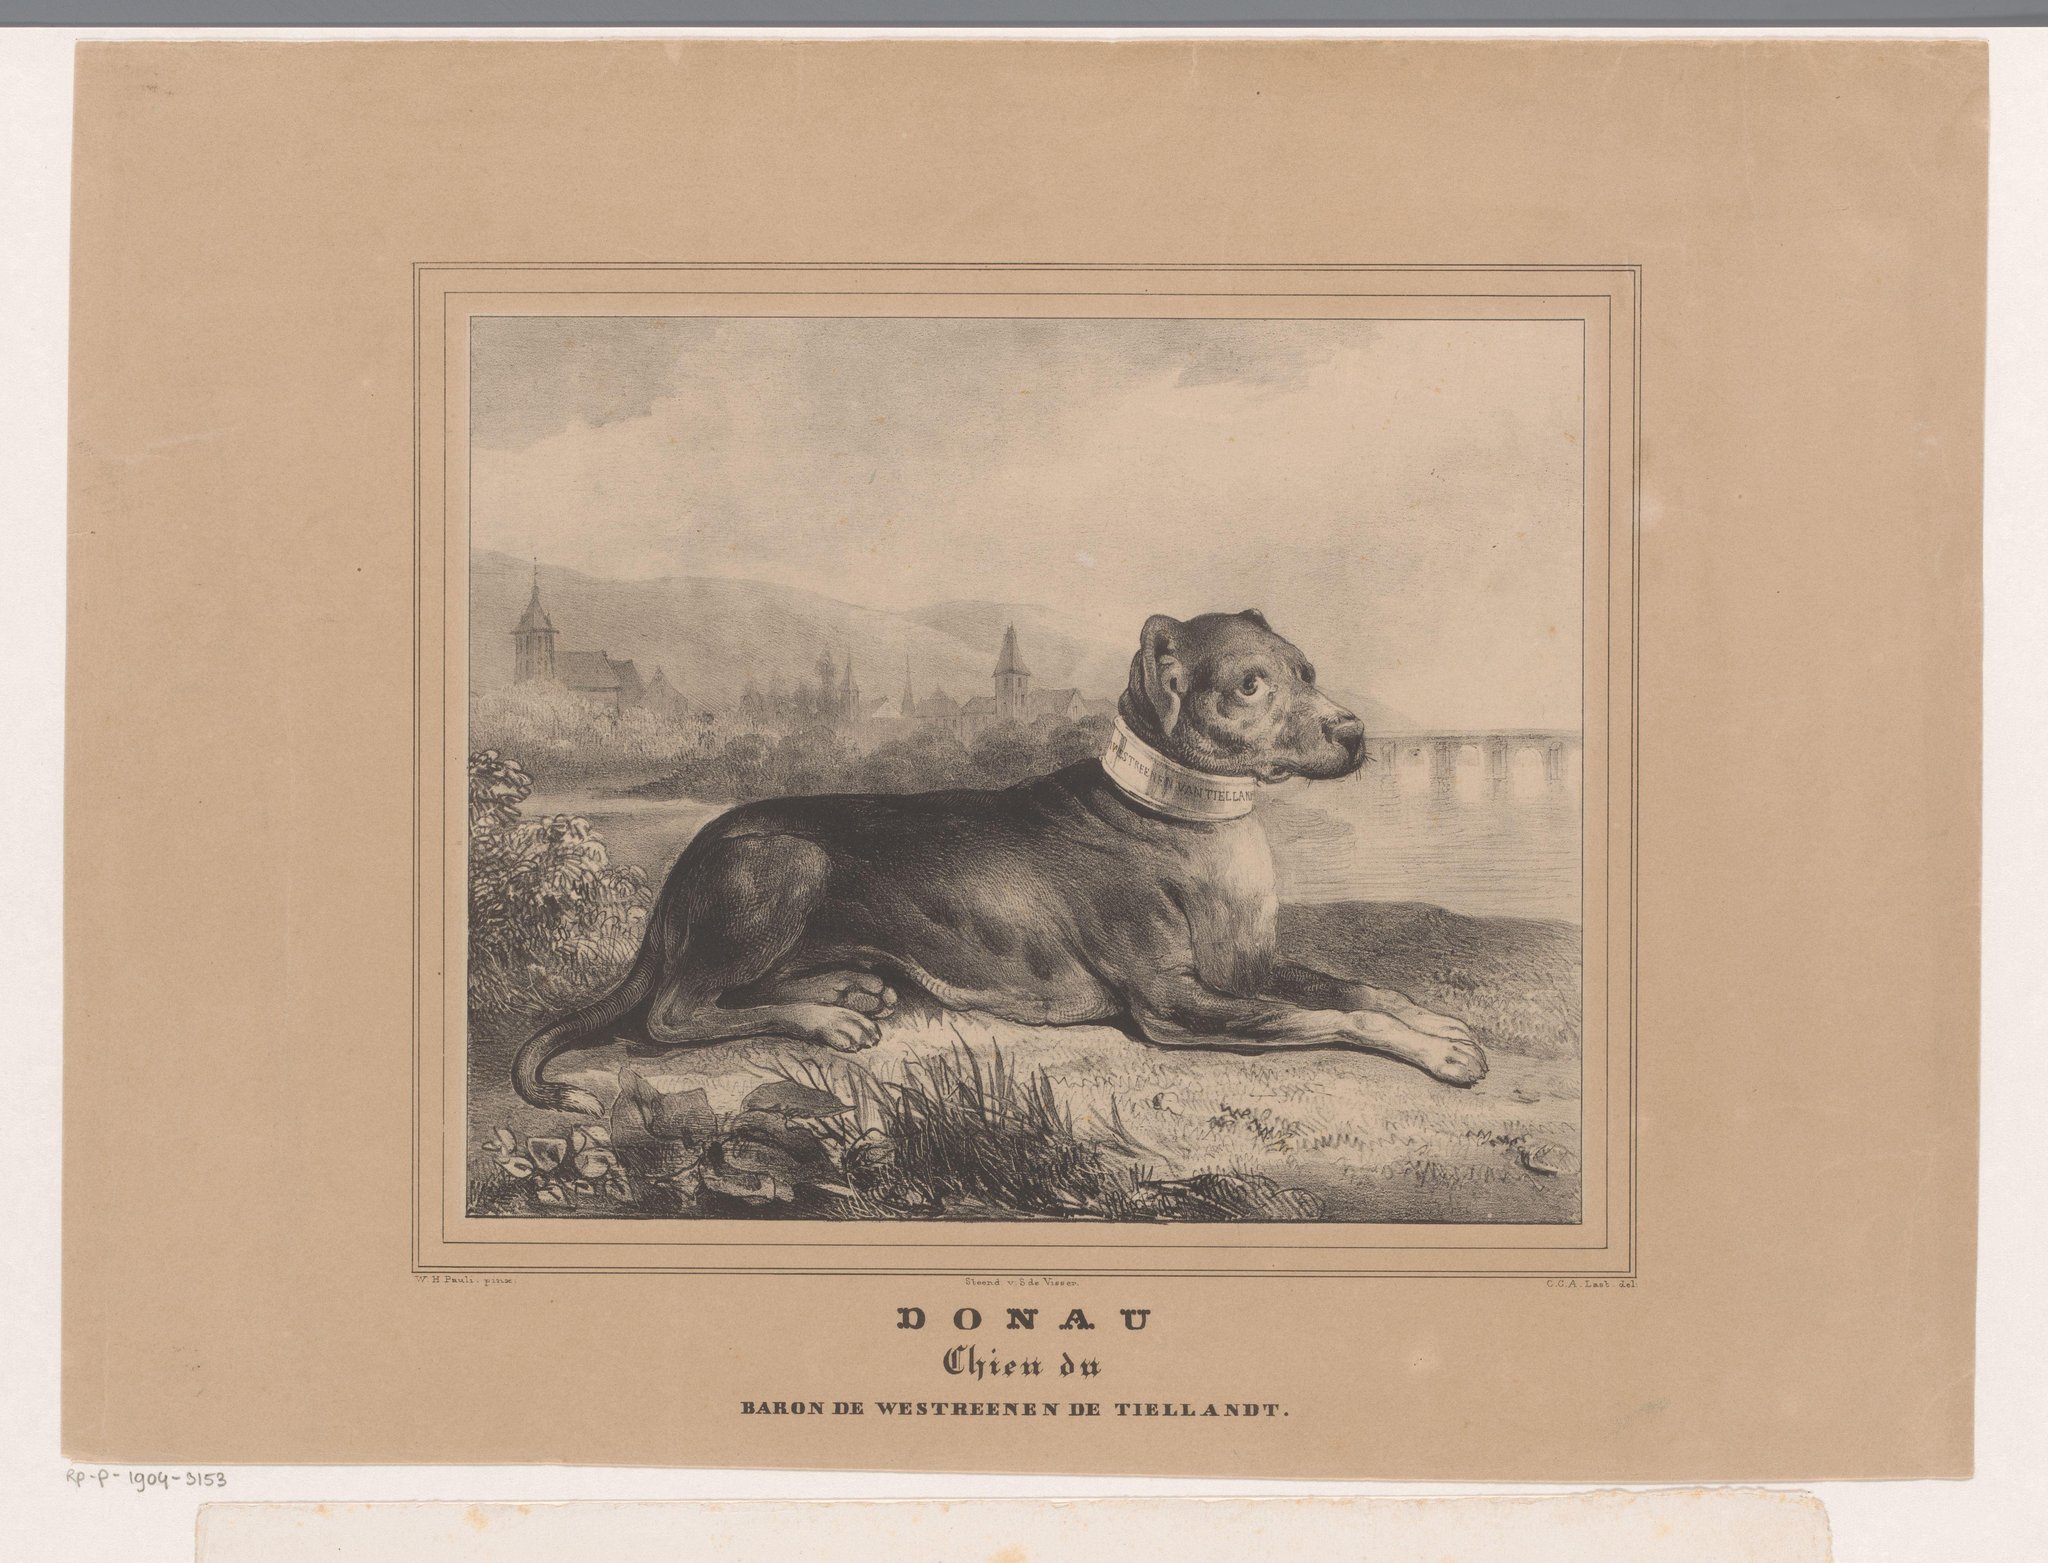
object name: print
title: Donau. Chien du Baron de Westreenen de Tiellandt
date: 1818-1848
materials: paper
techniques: lithograph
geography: the hague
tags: the hague, willem hendrik baron van westreenen van tiellandt, dog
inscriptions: collector's mark: Lugt 2228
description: De hond draagt een halsband met de naam van zijn baas Willem van Westreenen van Tiellandt.